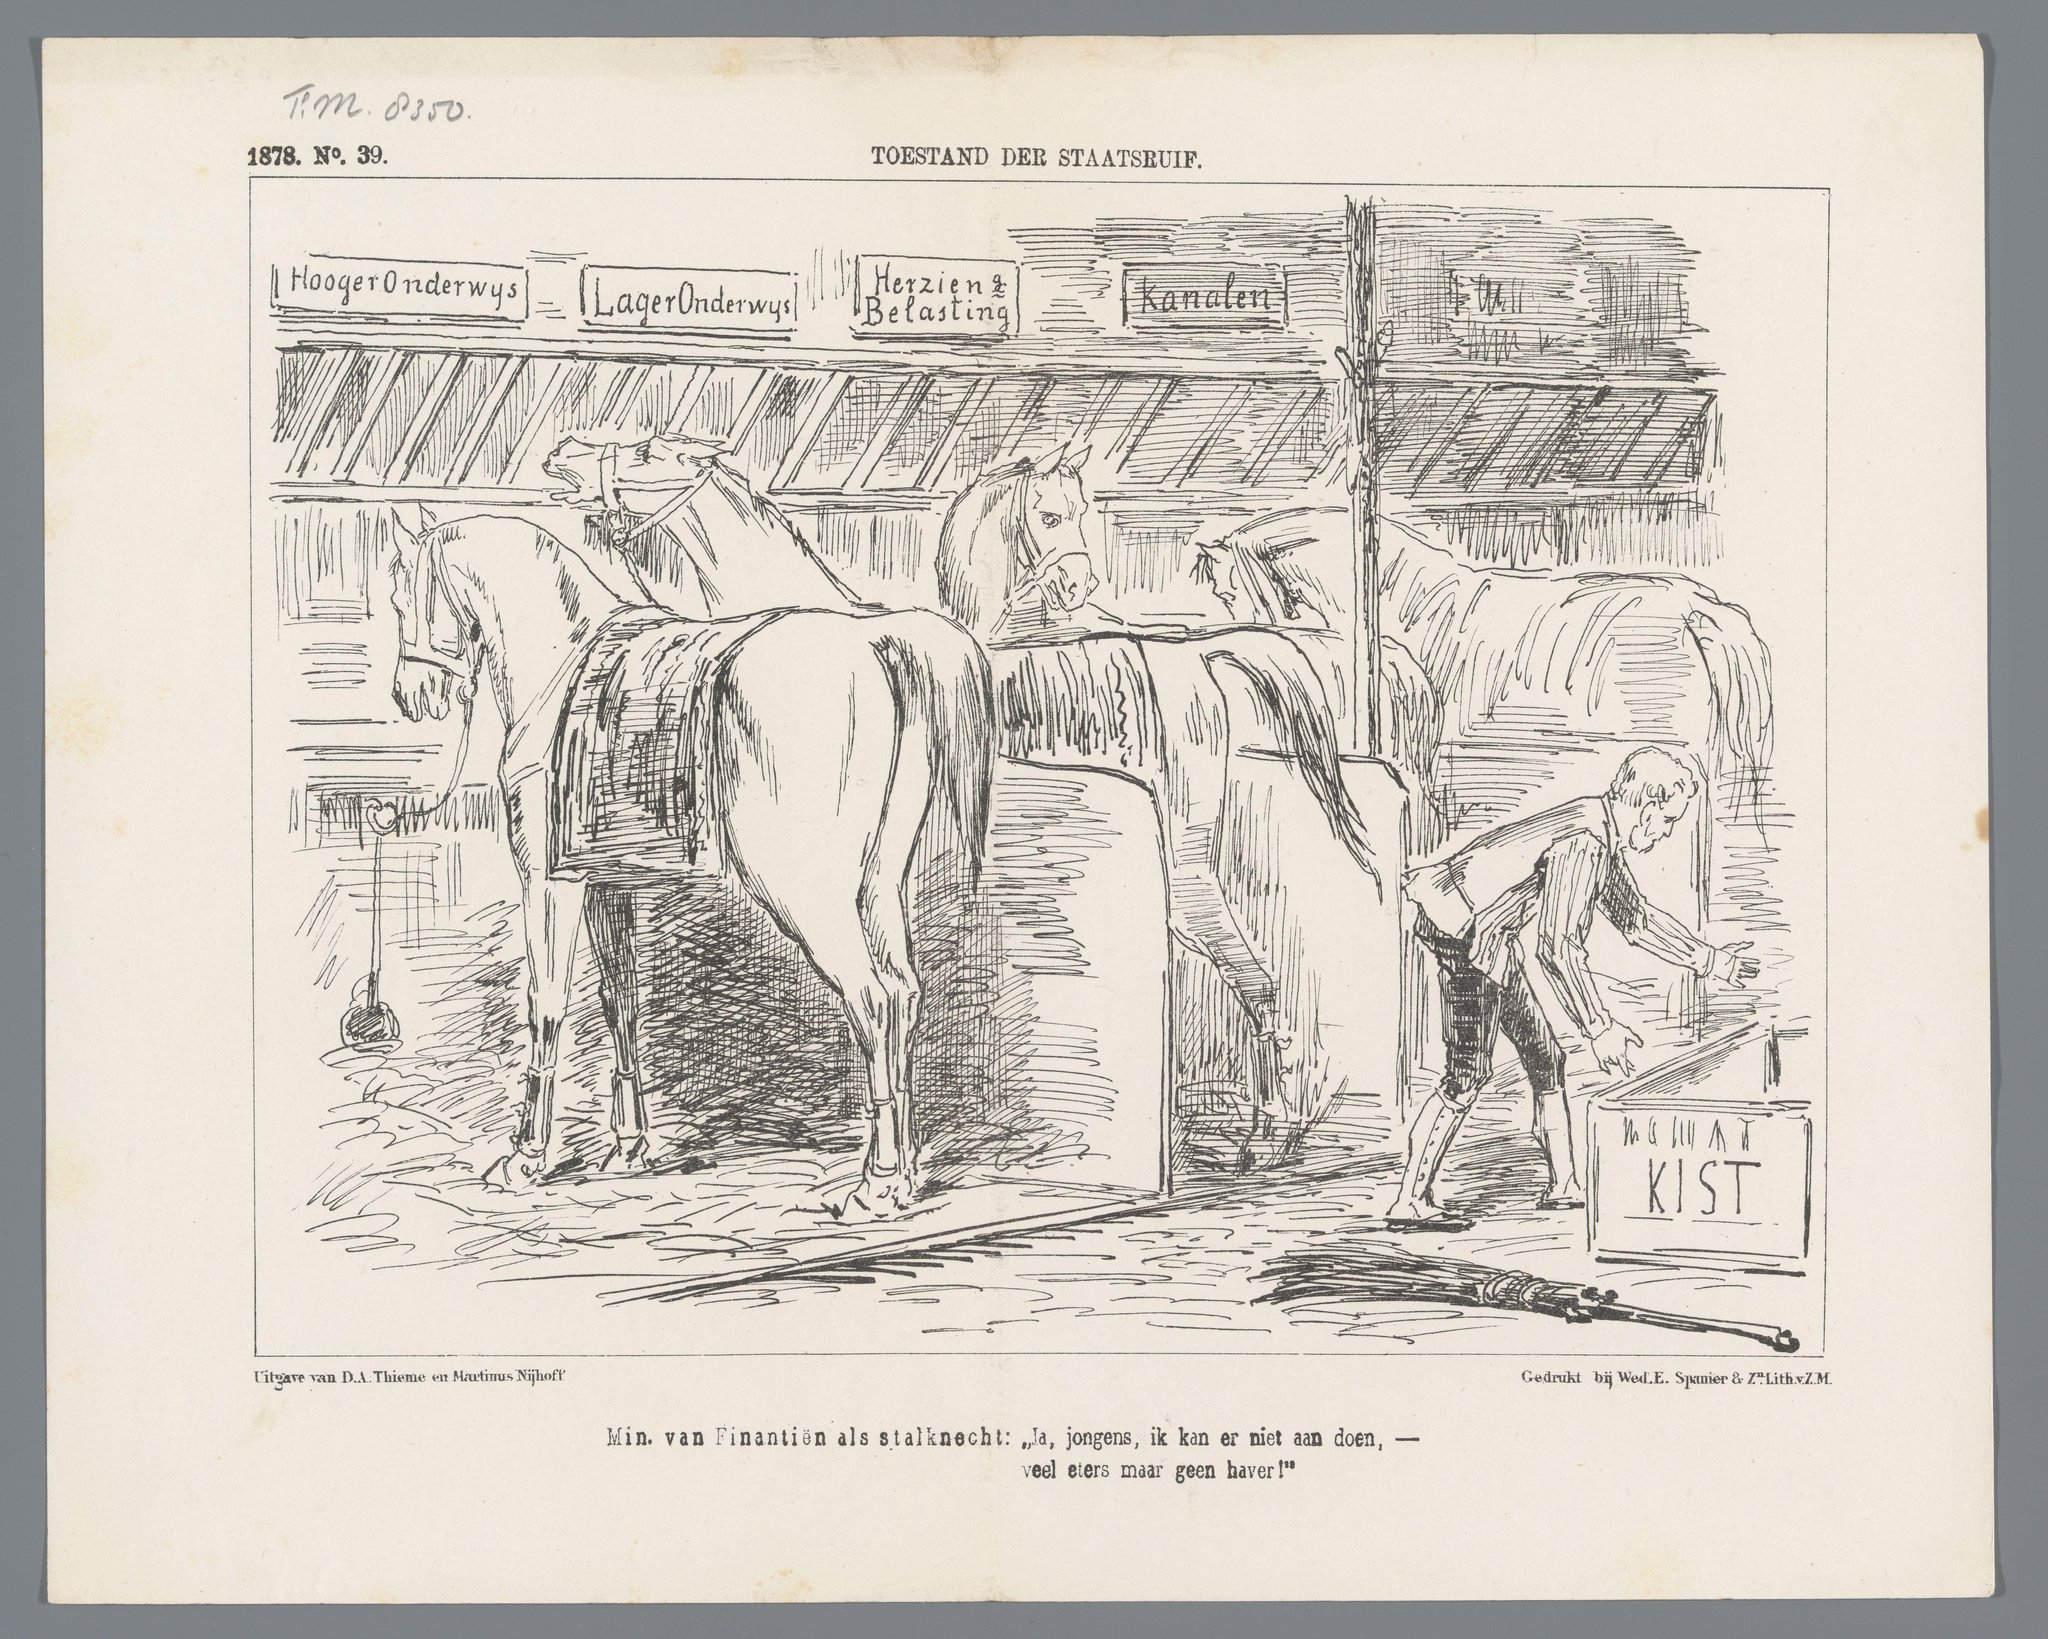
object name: print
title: Toestand der staatsruif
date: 1878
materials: paper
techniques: lithograph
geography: the hague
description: Spotprent. Plaat verschenen bij het weekblad De Nederlandsche Spectator, nr. 39, 1878.